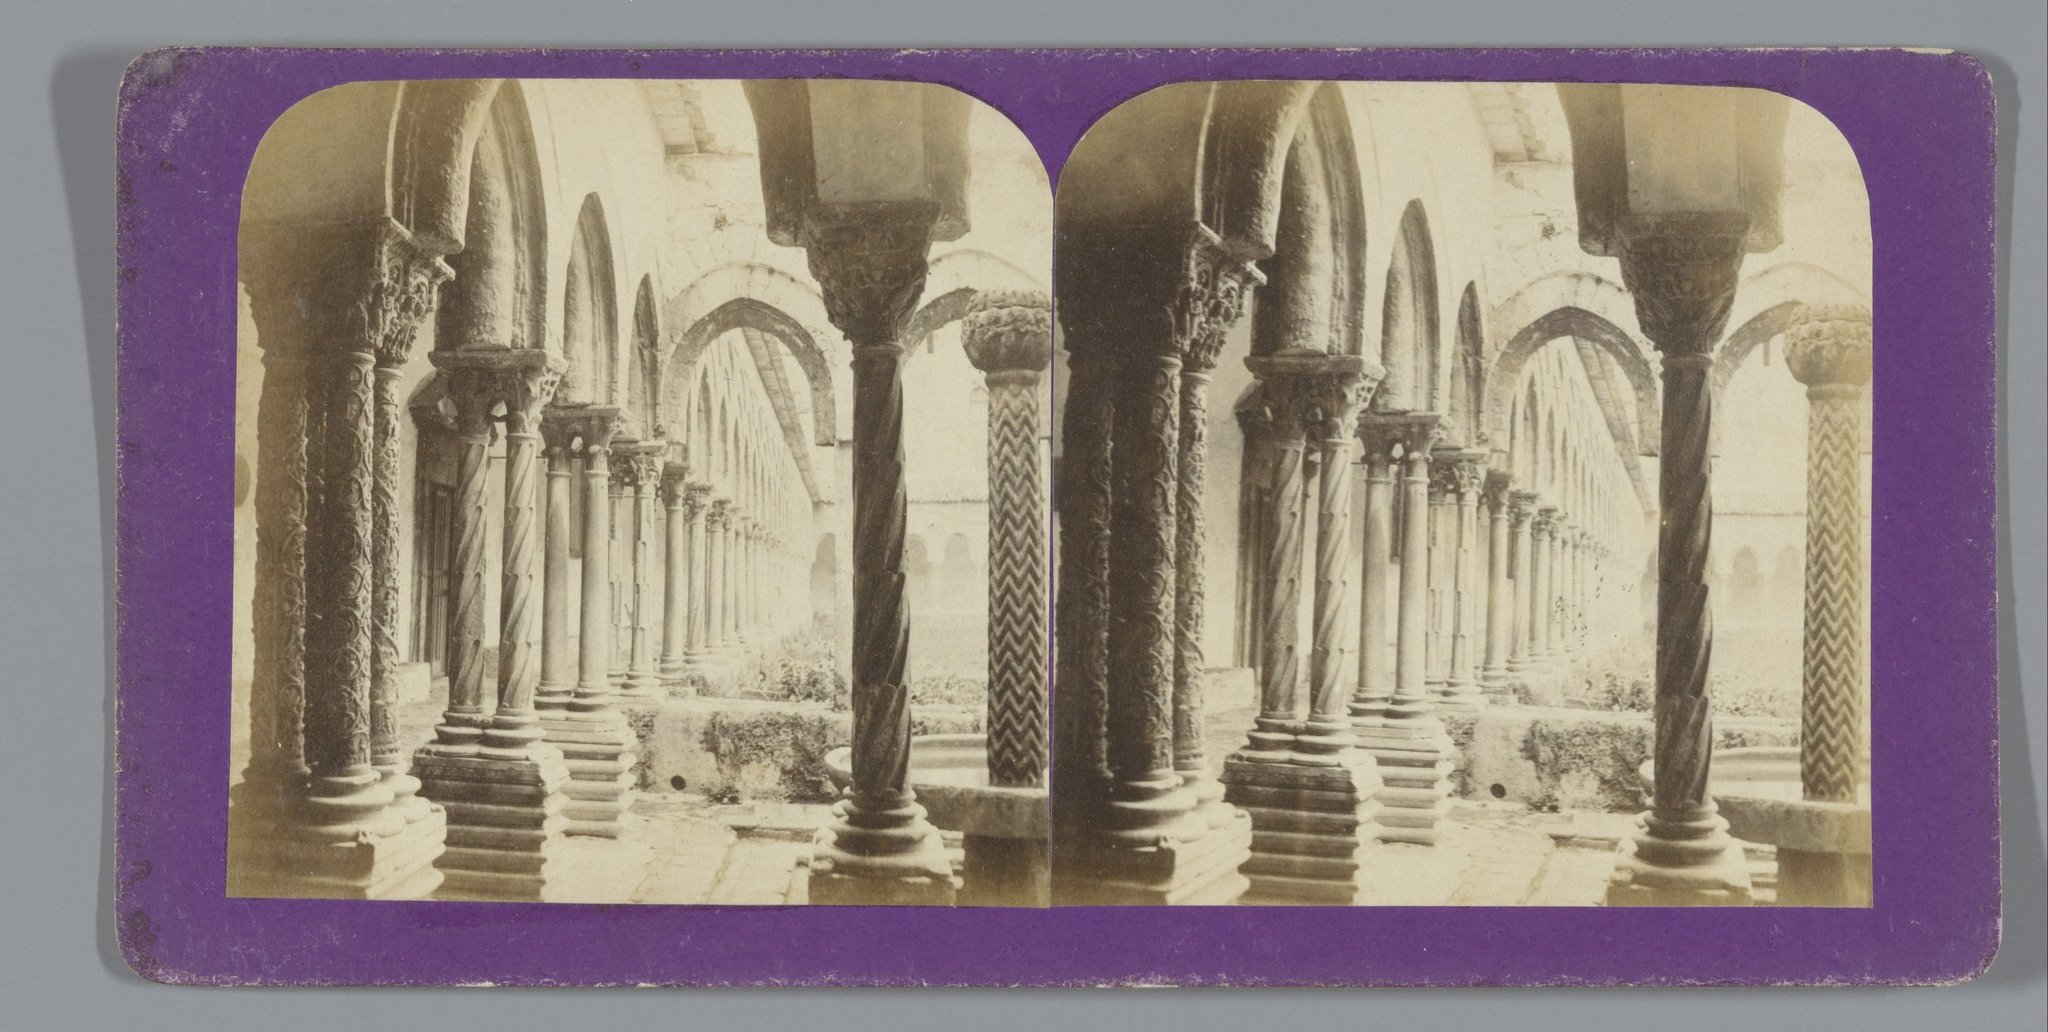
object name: stereograph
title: Cloitre du monastère de Montréal (Palerme)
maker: jean andrieu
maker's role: fotograaf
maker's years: 1816-1872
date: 1862-1876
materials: cardboard, paper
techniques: albumen print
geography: palermo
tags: abbey, monastery, convent ~ roman catholic church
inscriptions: title: ‘1629 Cloitre du monastère de Montréal (Palerme)’